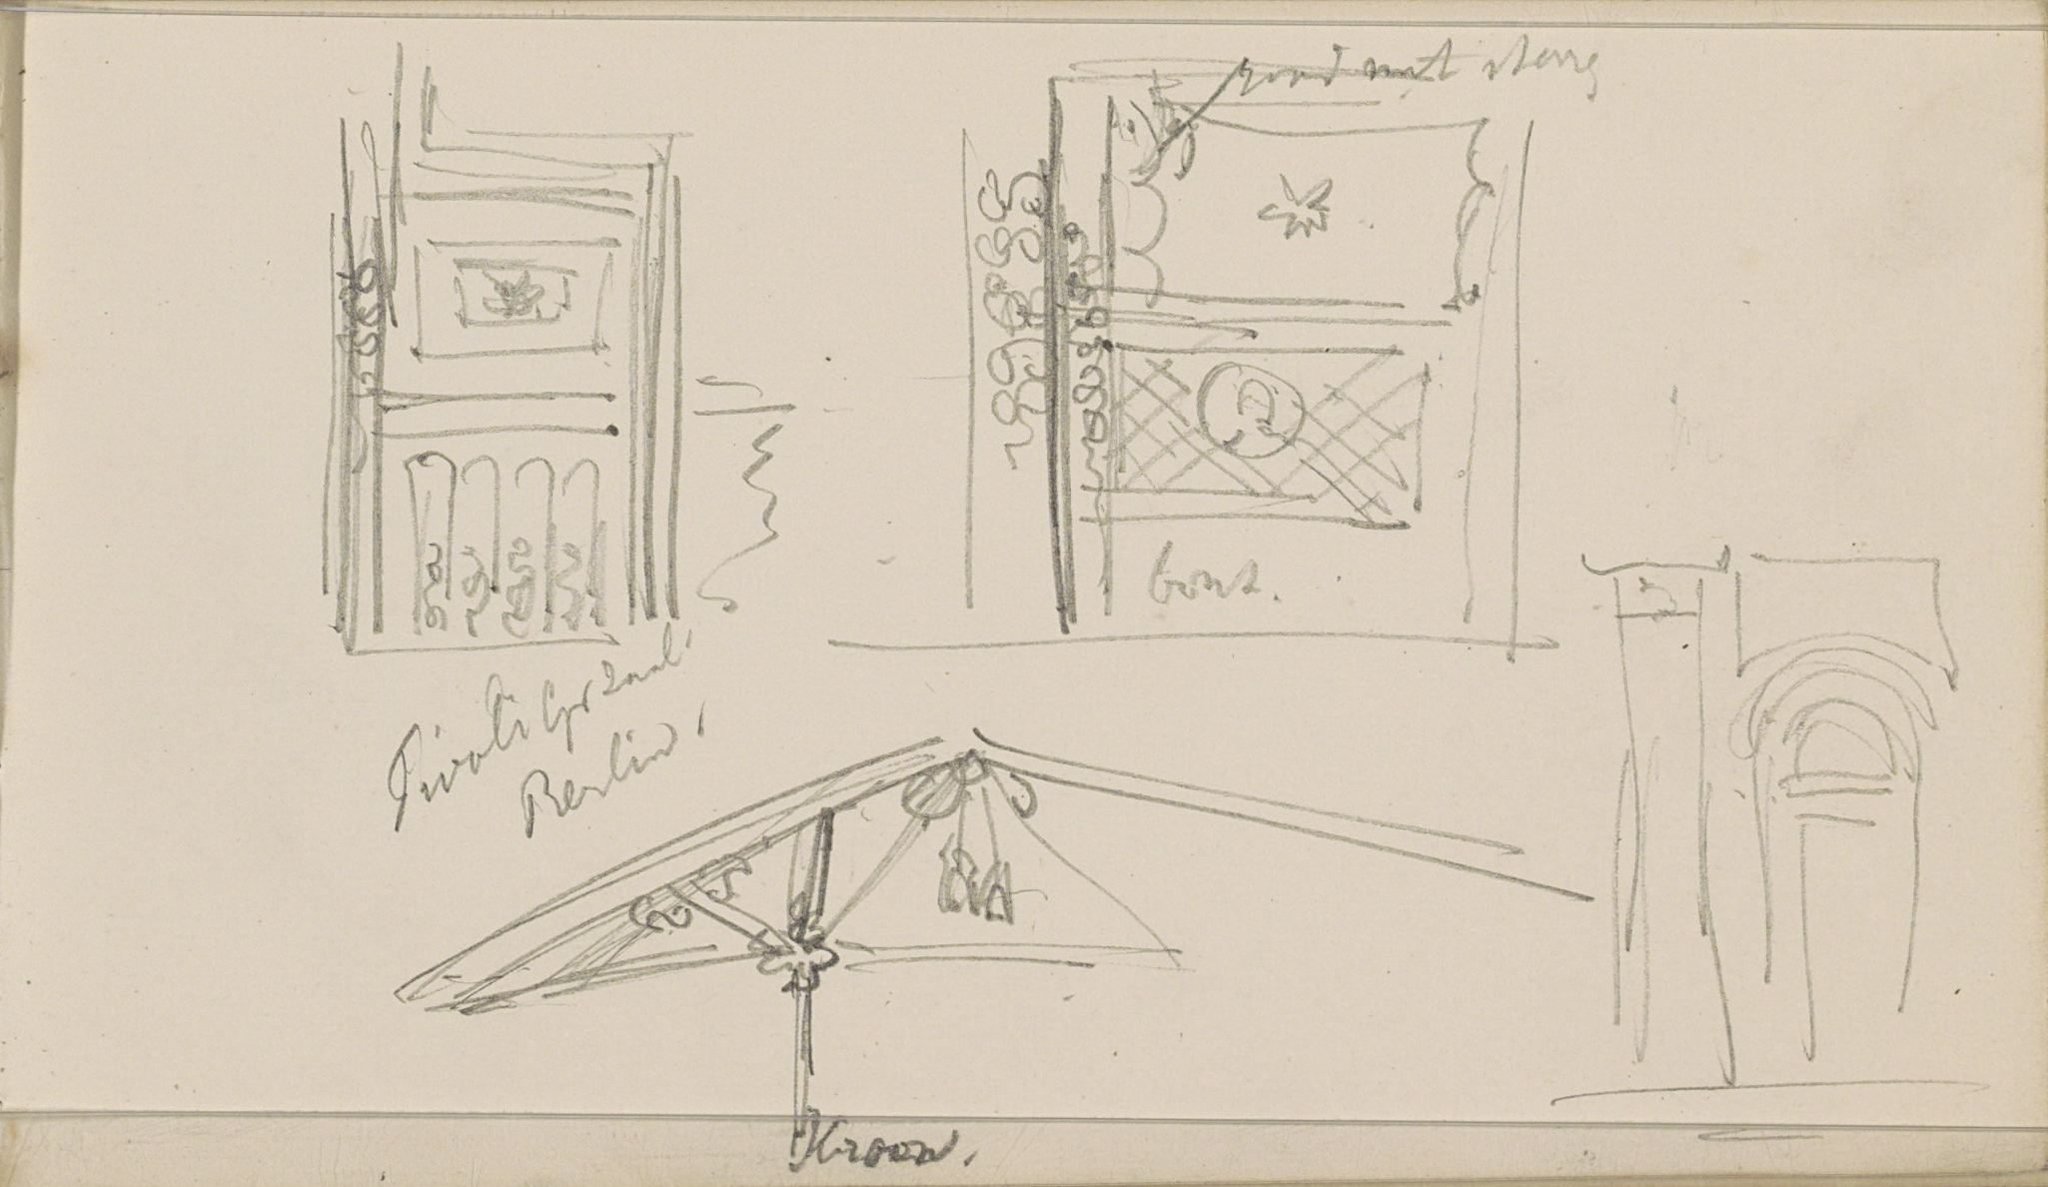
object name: sketchbook leaf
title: Architecturale details van de grote zaal van de Tivoli brouwerij te Berlijn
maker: isaac gosschalk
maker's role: draughtsman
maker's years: 1838-1907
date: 1866-1868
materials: paper, pencil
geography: berlin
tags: architectural detail, berlin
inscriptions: annotation: ‘Tivoli Gr zaal/ Berlin/ [...]/ kroon’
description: Onder andere wandbespanning en een kroonlijst. Blad 18 recto uit een schetsboek met 67 bladen.